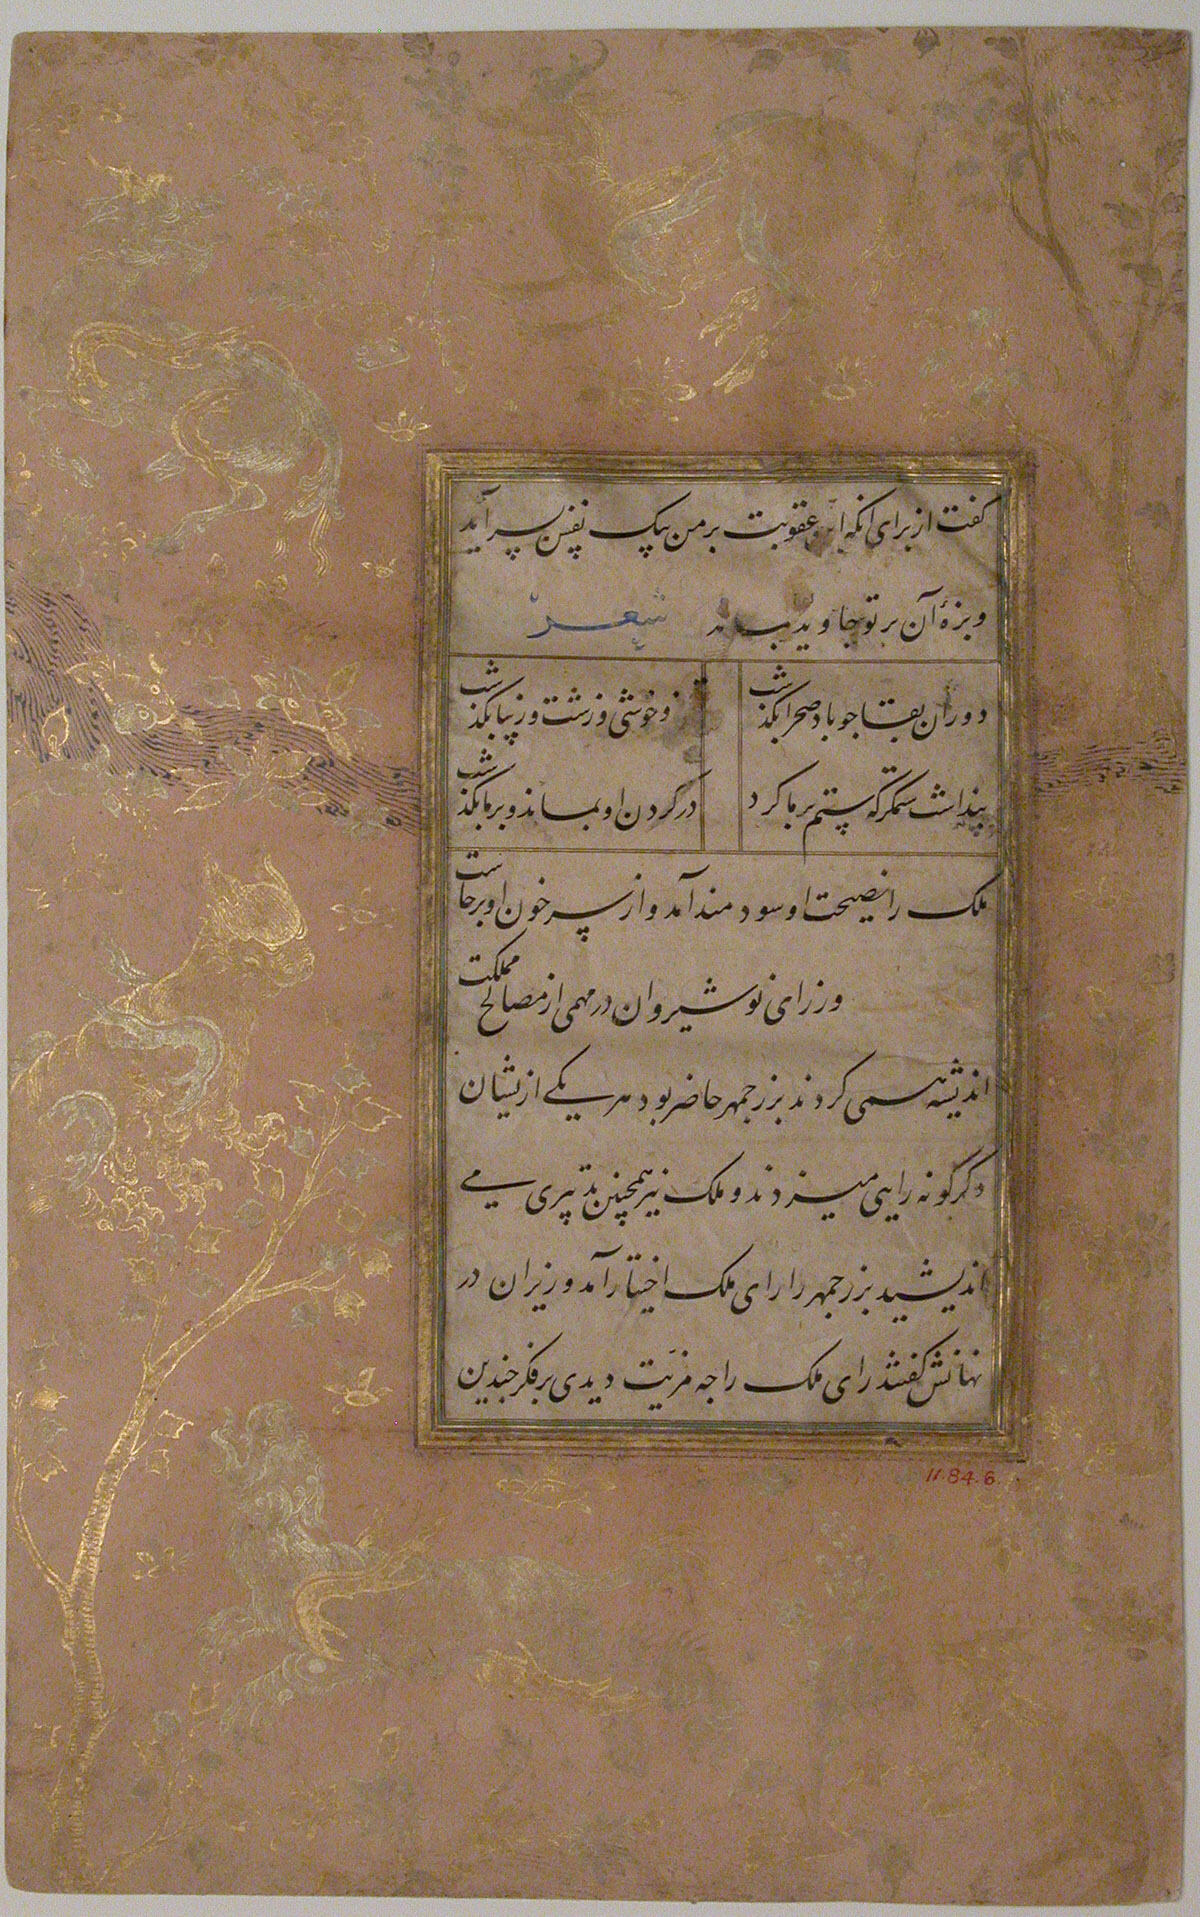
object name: folio from a non illustrated manuscript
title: Page of Calligraphy from an Anthology of Poetry by Sa`di and Hafiz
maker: sa'di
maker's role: author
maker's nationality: iranian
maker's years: 1213-1291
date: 1467-1500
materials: gold, ink, paper, silver, watercolor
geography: afghanistan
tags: animals,poetry,calligraphy